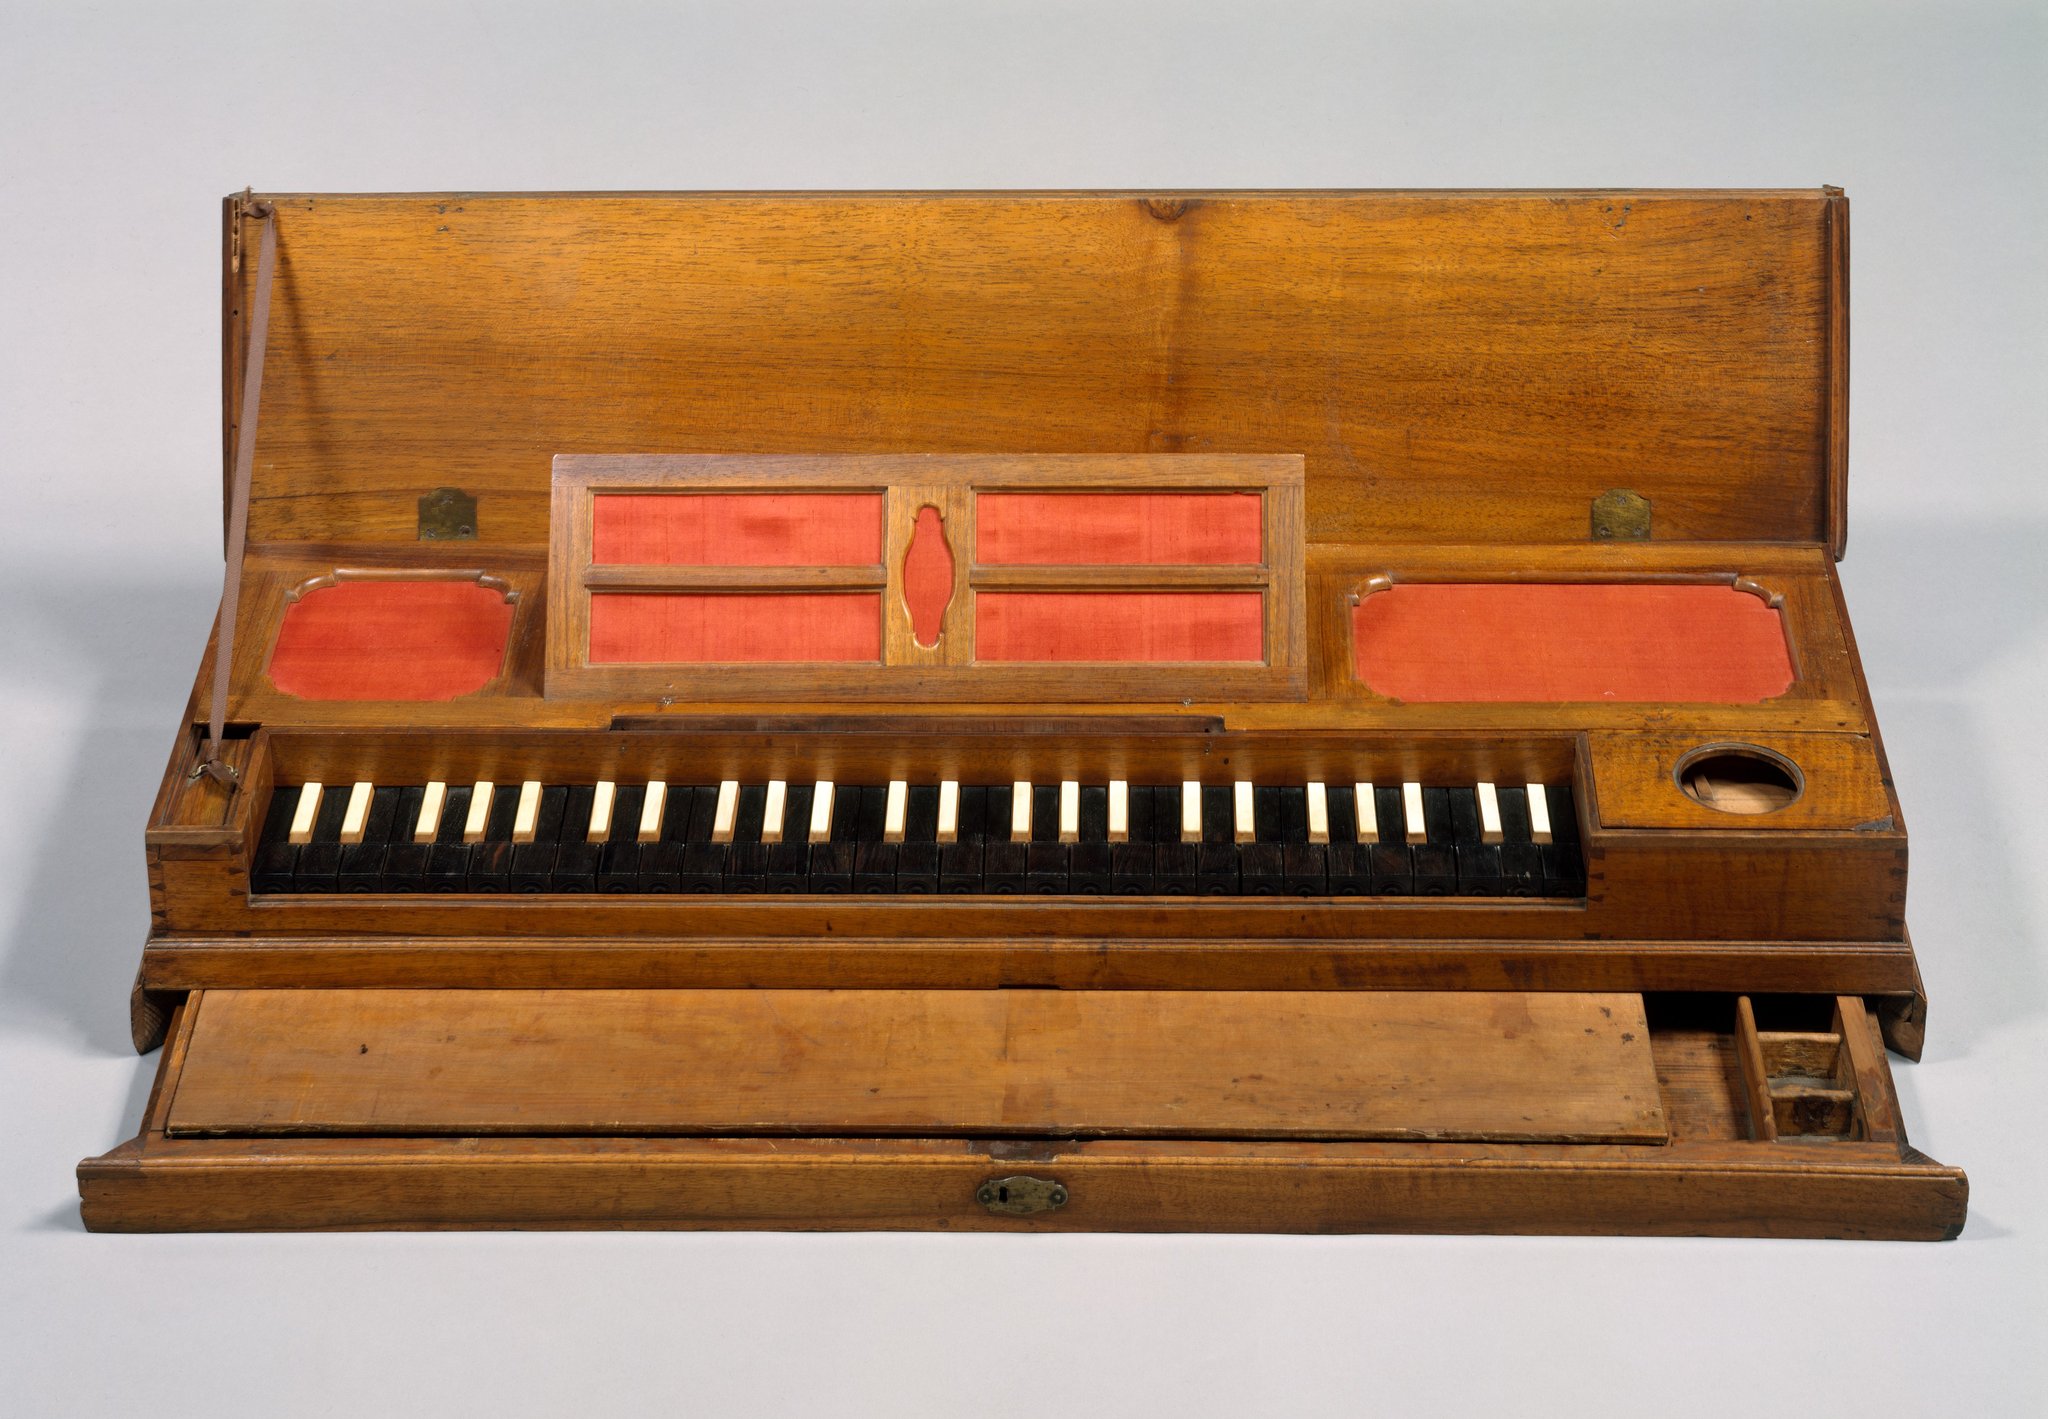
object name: clavichord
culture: german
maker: johann heinrich gräbner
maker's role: maker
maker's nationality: german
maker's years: 1700-1777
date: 1701-1800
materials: wood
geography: germany